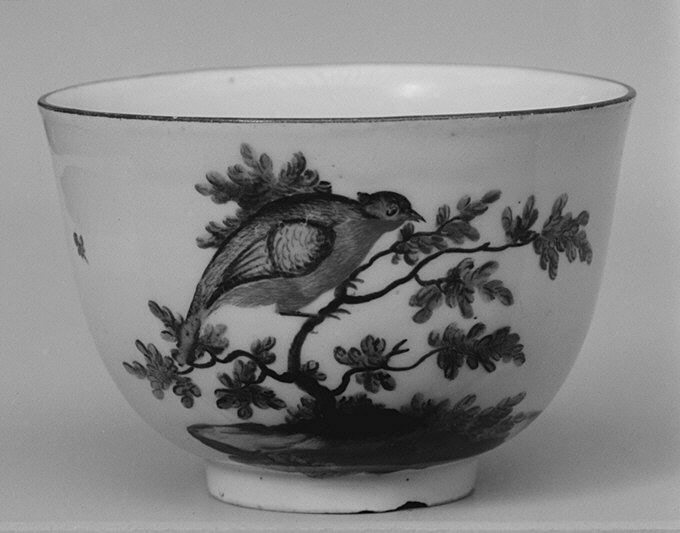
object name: cup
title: Cup (part of a service)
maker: frankenthal porcelain manufactory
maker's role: manufactory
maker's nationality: german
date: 1770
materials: hard paste porcelain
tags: birds,plants